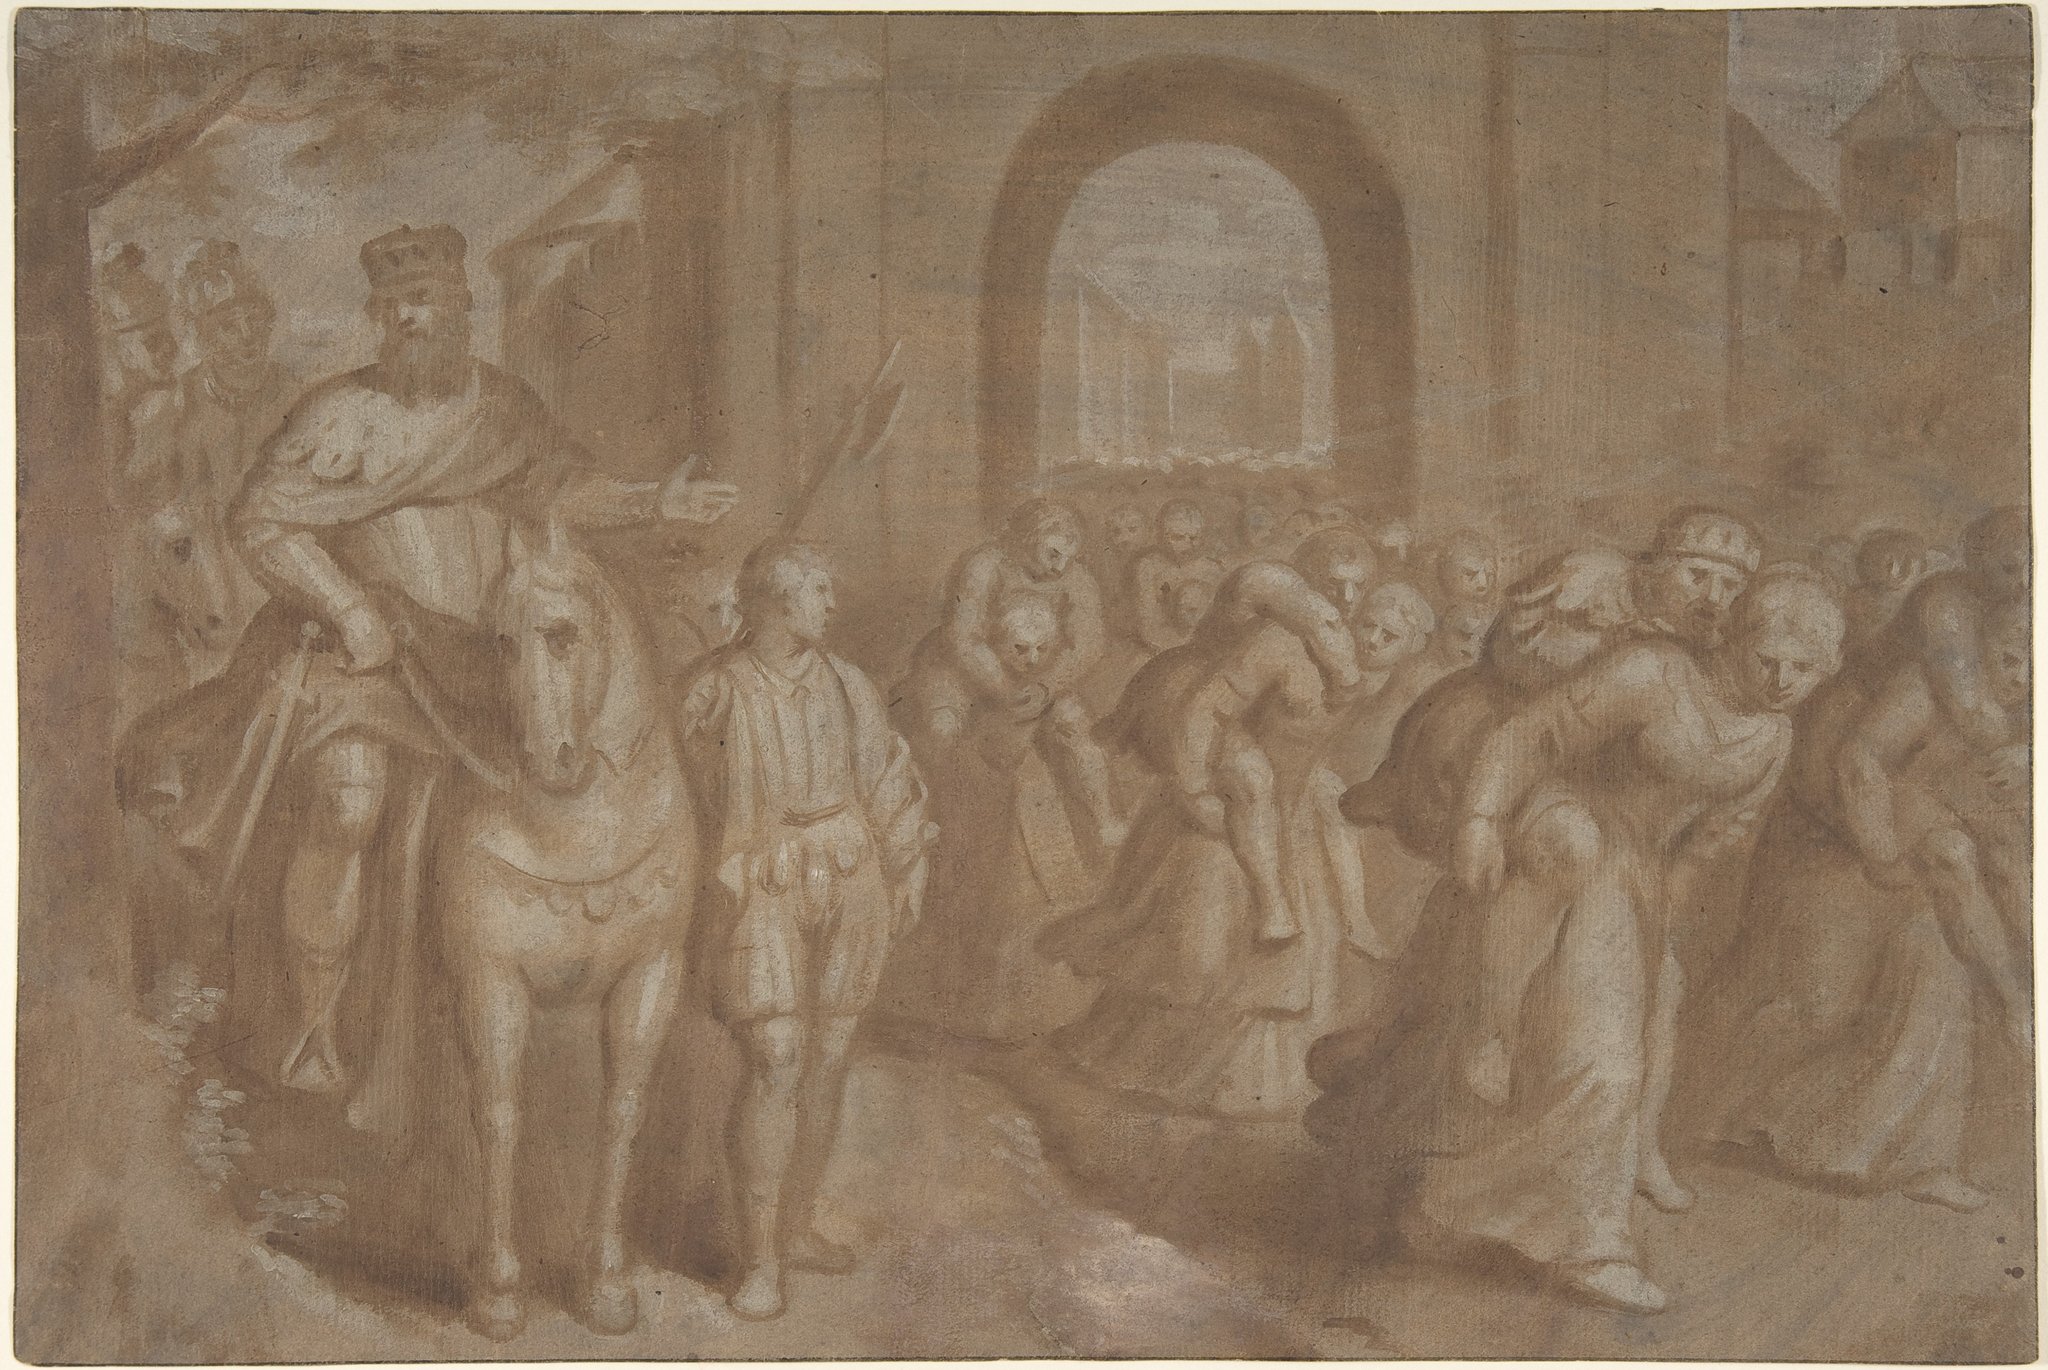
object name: drawing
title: The Women of Weinsberg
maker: otto van veen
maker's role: artist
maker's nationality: netherlandish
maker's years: 1556-1629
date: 1567-1633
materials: ink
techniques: brush, pen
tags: men,women,horses